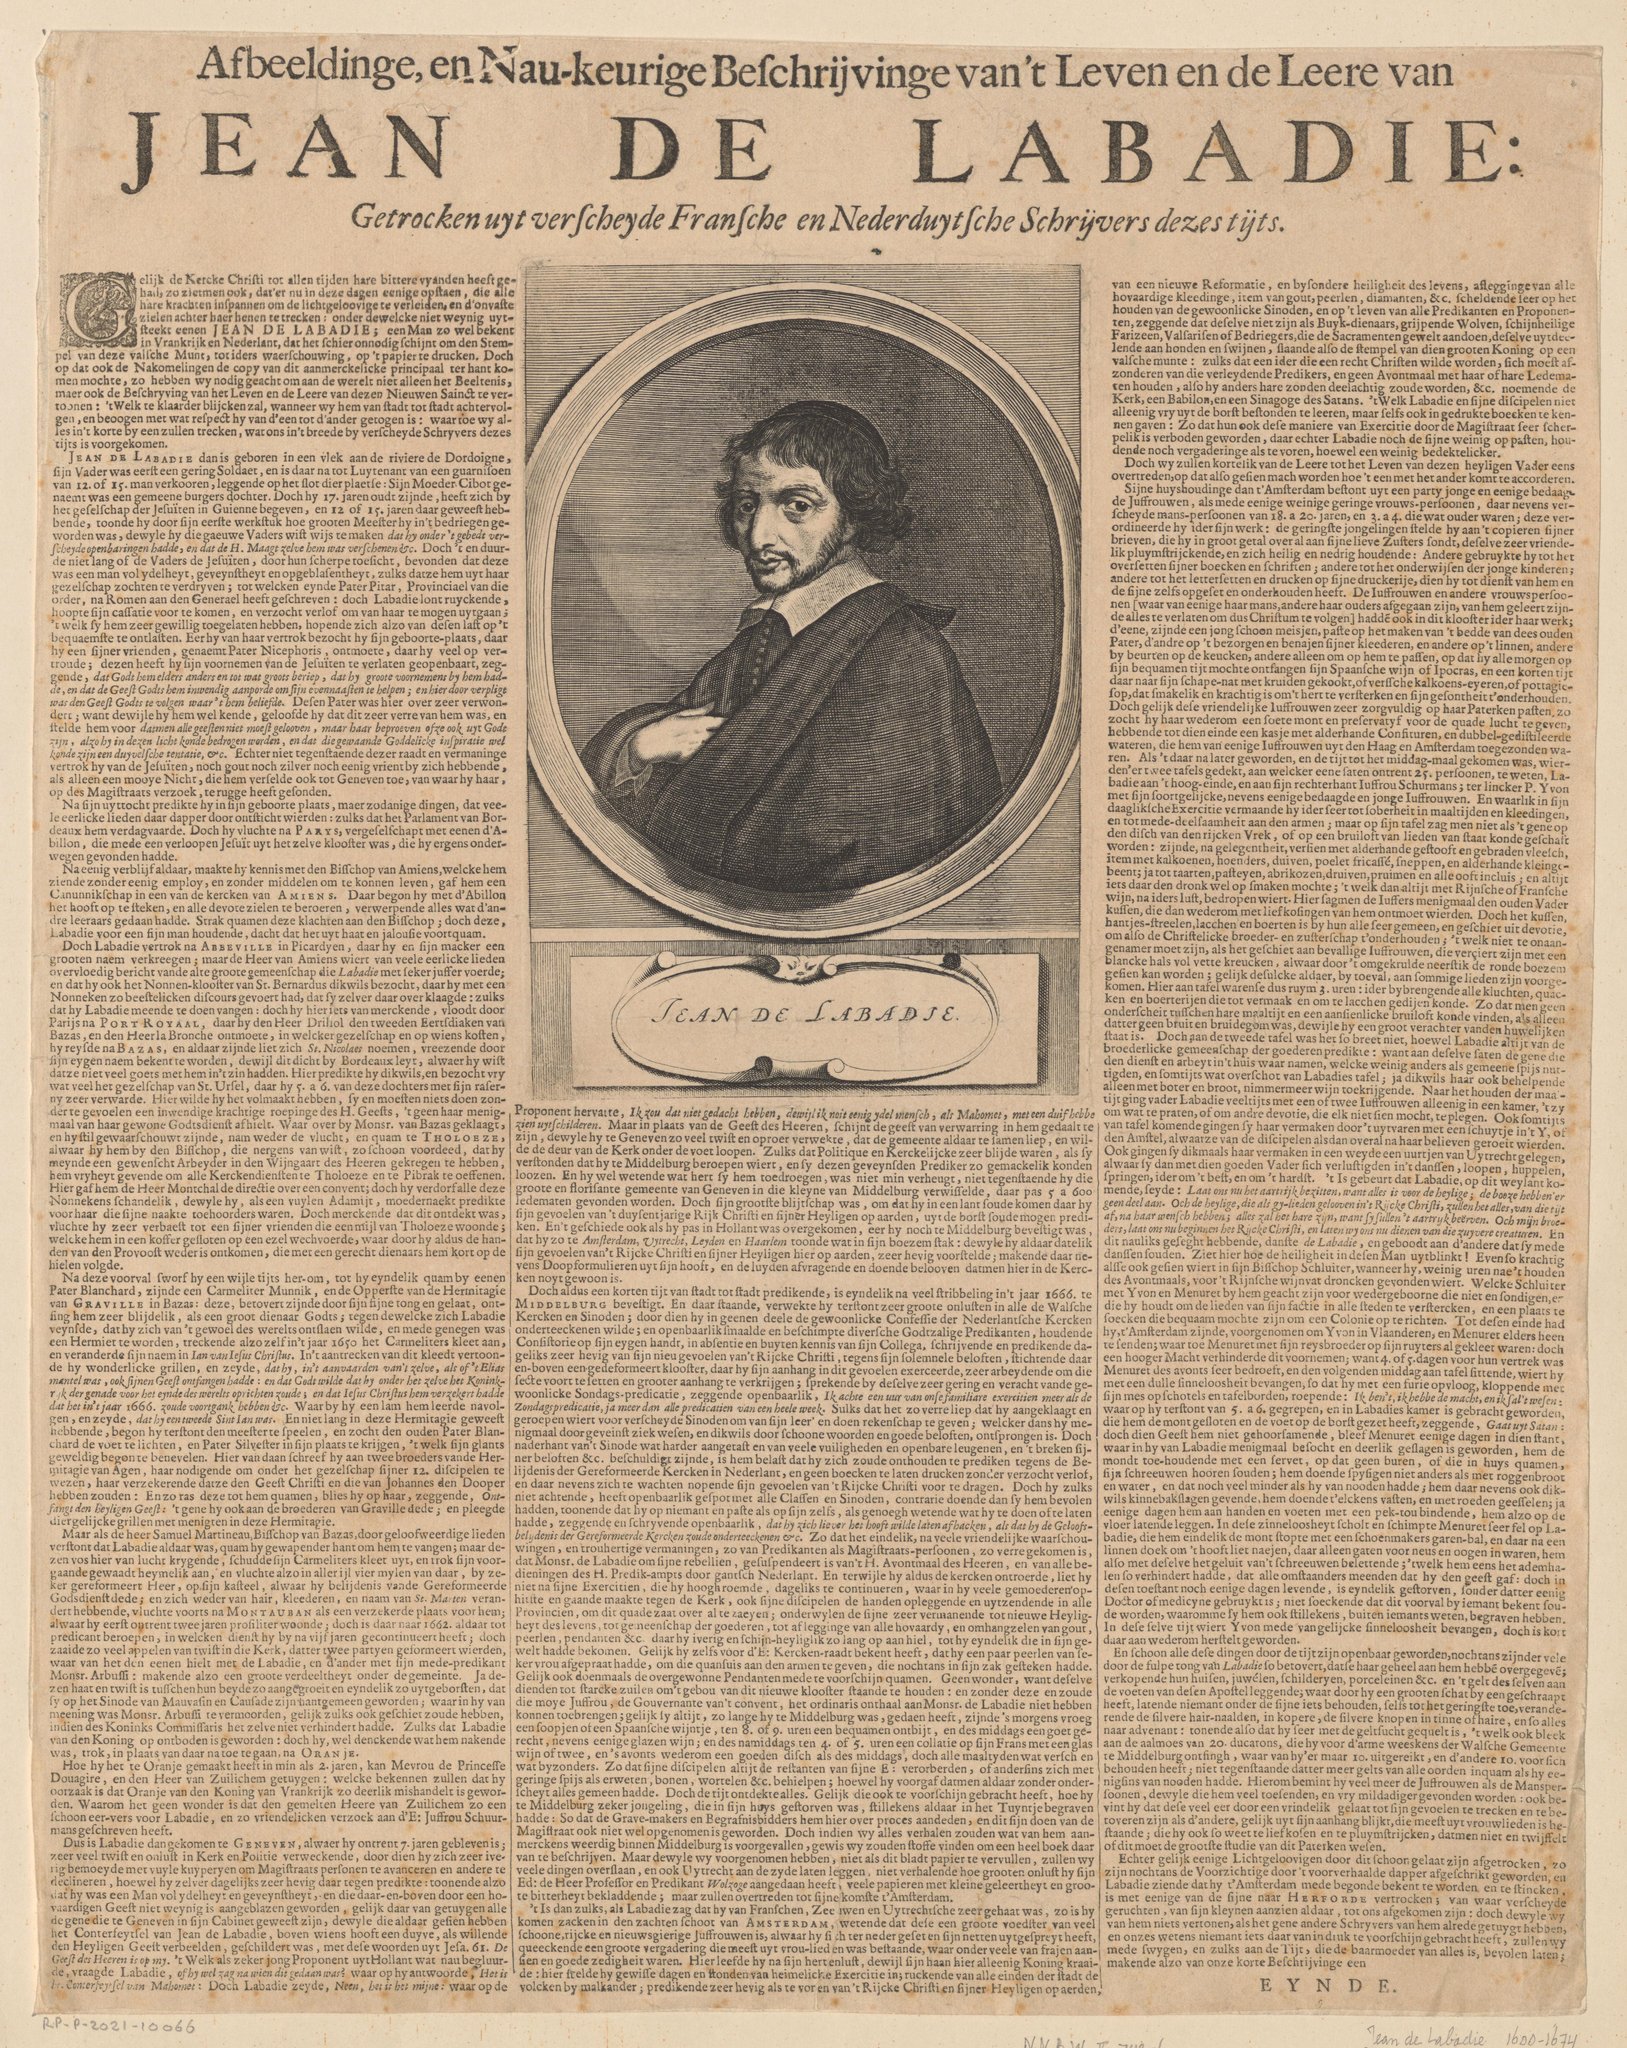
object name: print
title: Afbeeldinge, en nau-keurige beschrijvinge van 't leven en de Leere van Jean de Labadie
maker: Anonymous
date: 1670-1699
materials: paper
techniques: engraving, letterpress printing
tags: historical persons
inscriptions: collector's mark: Lugt 240